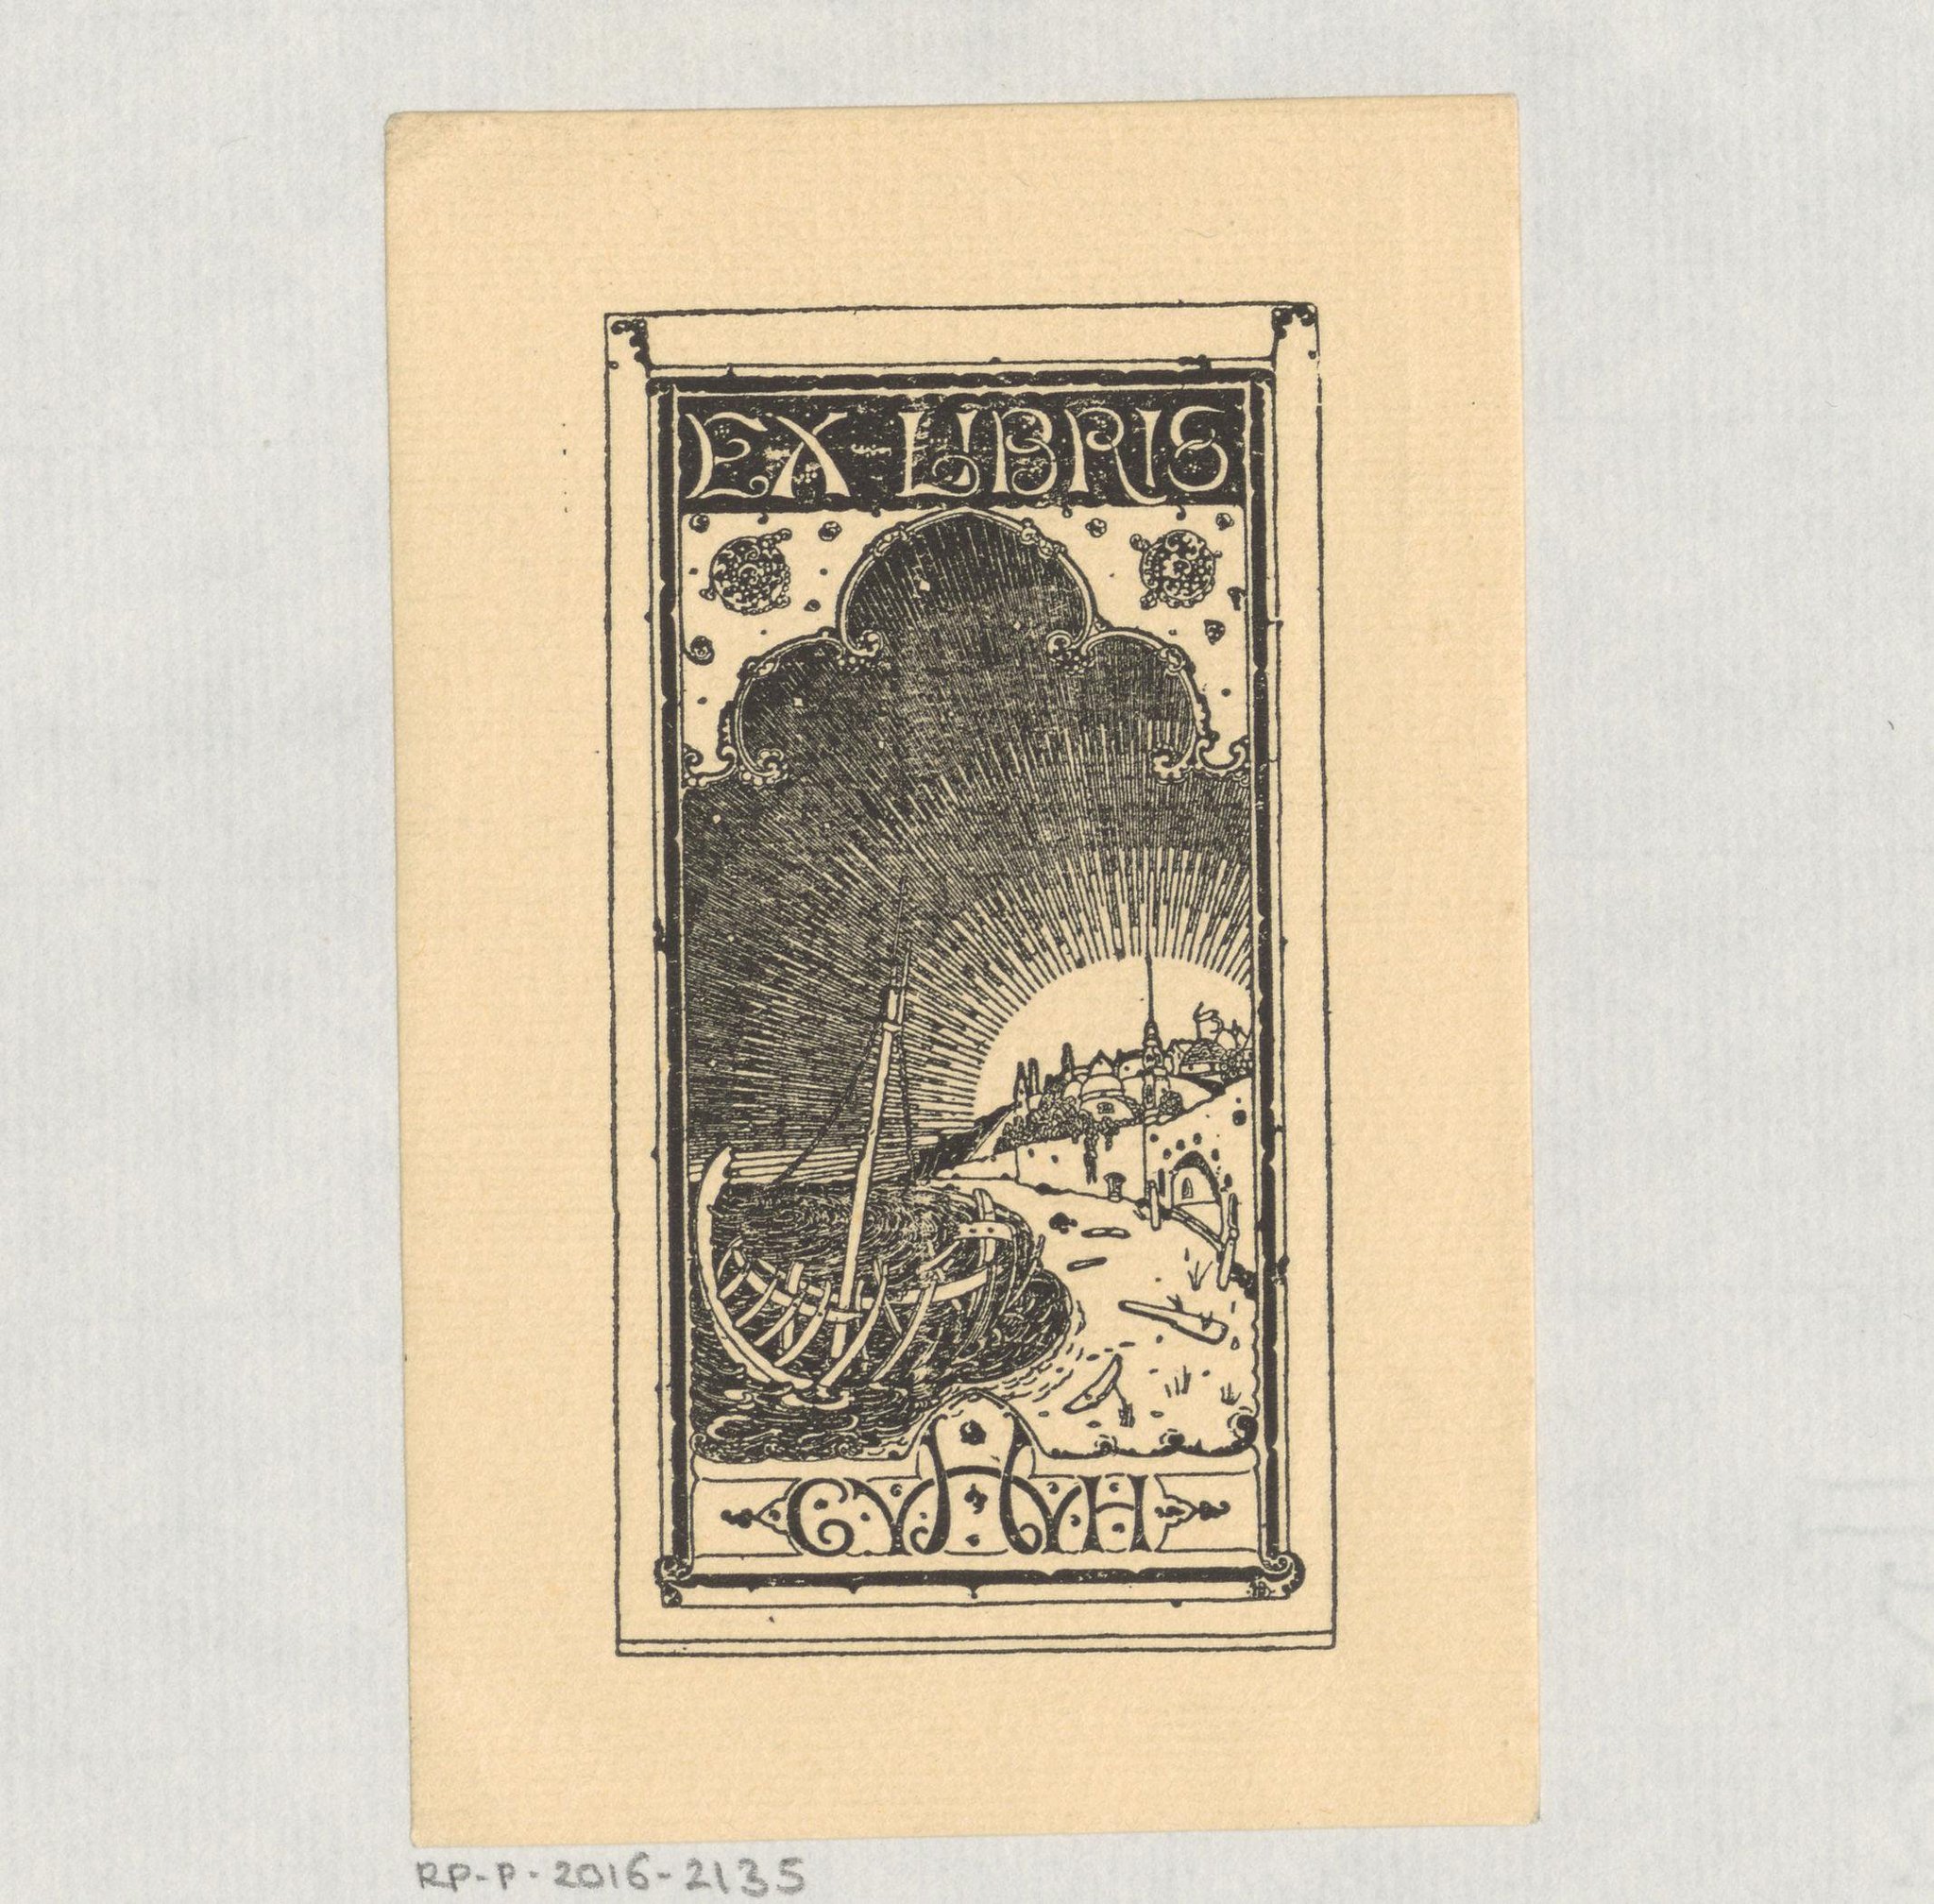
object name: bookplate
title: Ex libris van C.v.H.v.H.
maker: Anonymous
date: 1850-1950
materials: paper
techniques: printing block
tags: dale, valley, shipwreck, prospect of city, town panorama, silhouette of city